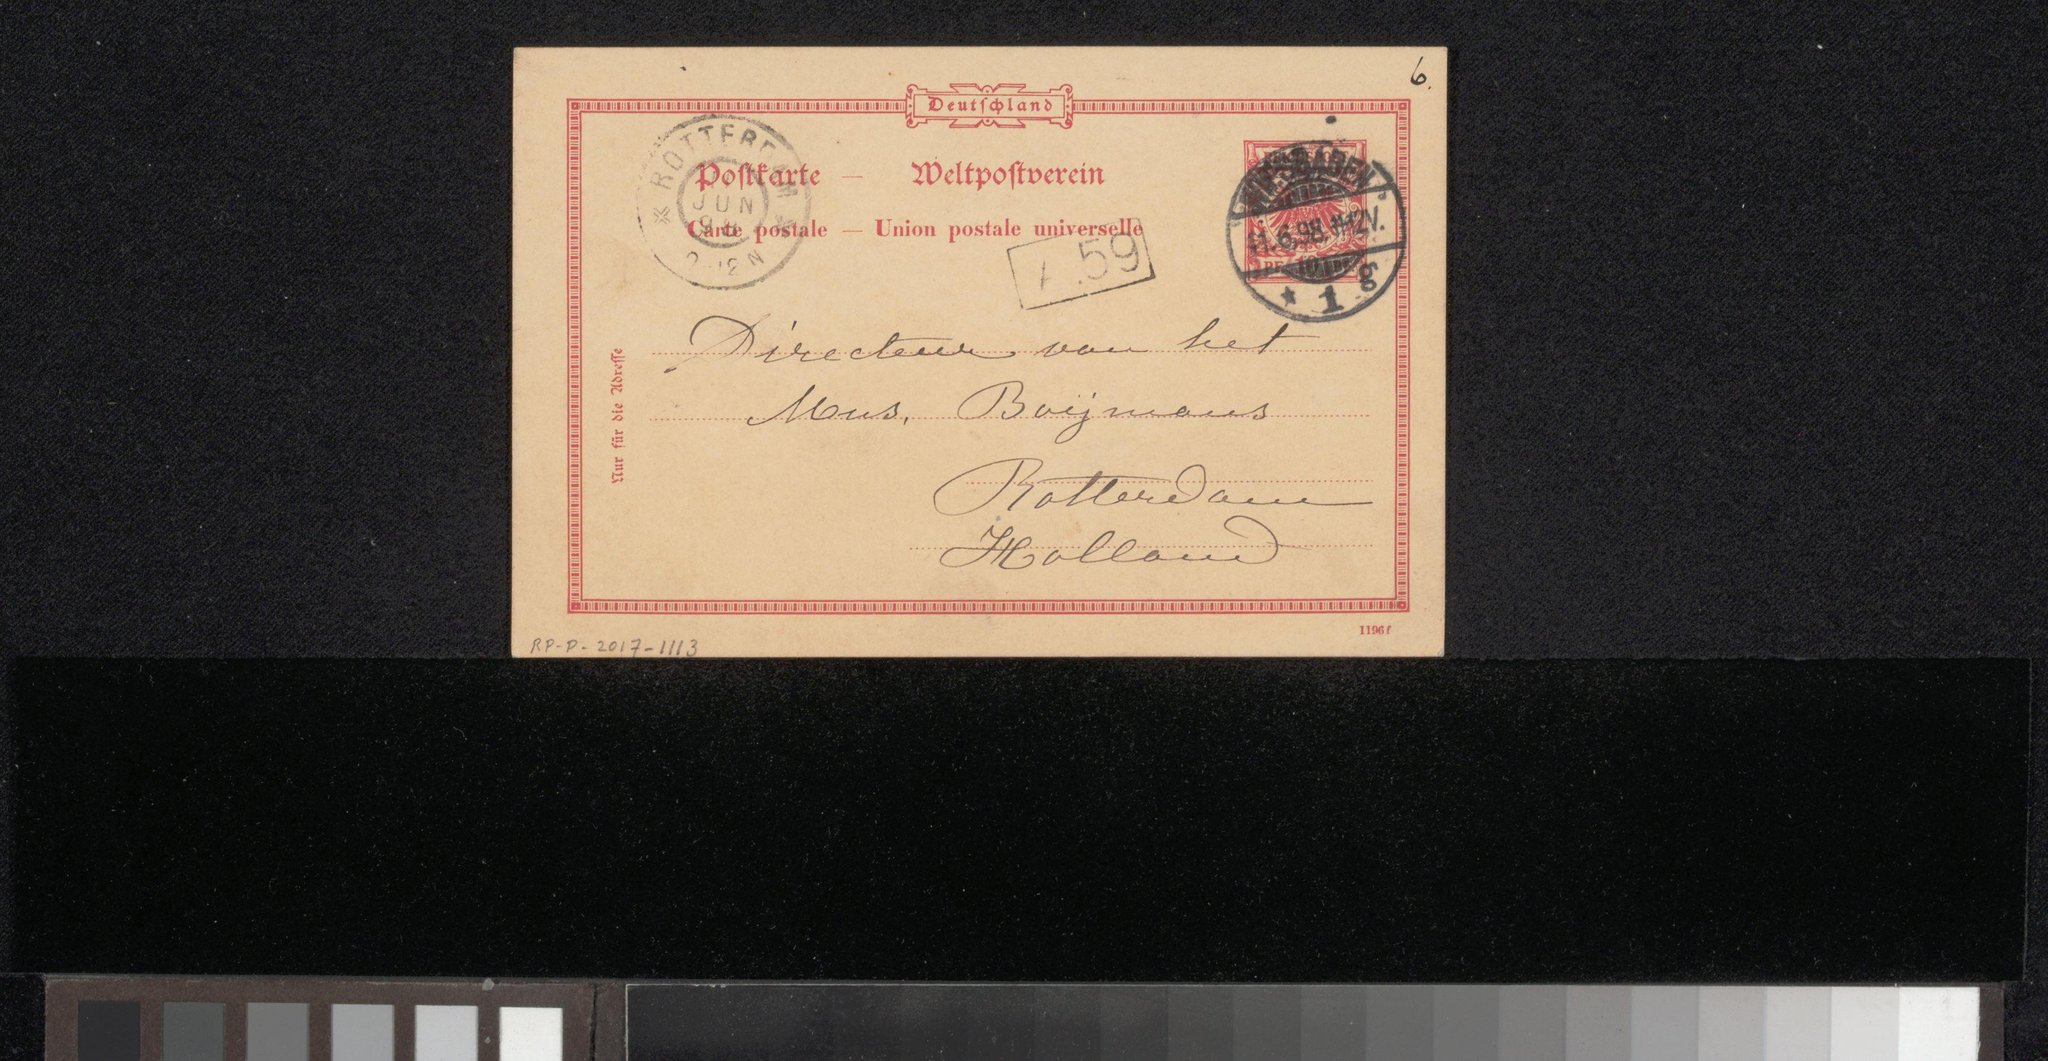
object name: postcard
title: Briefkaart aan Pieter Haverkorn van Rijsewijk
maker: mevrouw cremers van de velde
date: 1898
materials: cardboard, ink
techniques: pen, writing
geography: wiesbaden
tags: rome, draughtsman, designer, sculptor, pier pander, pieter haverkorn van rijsewijk, sculpture, money